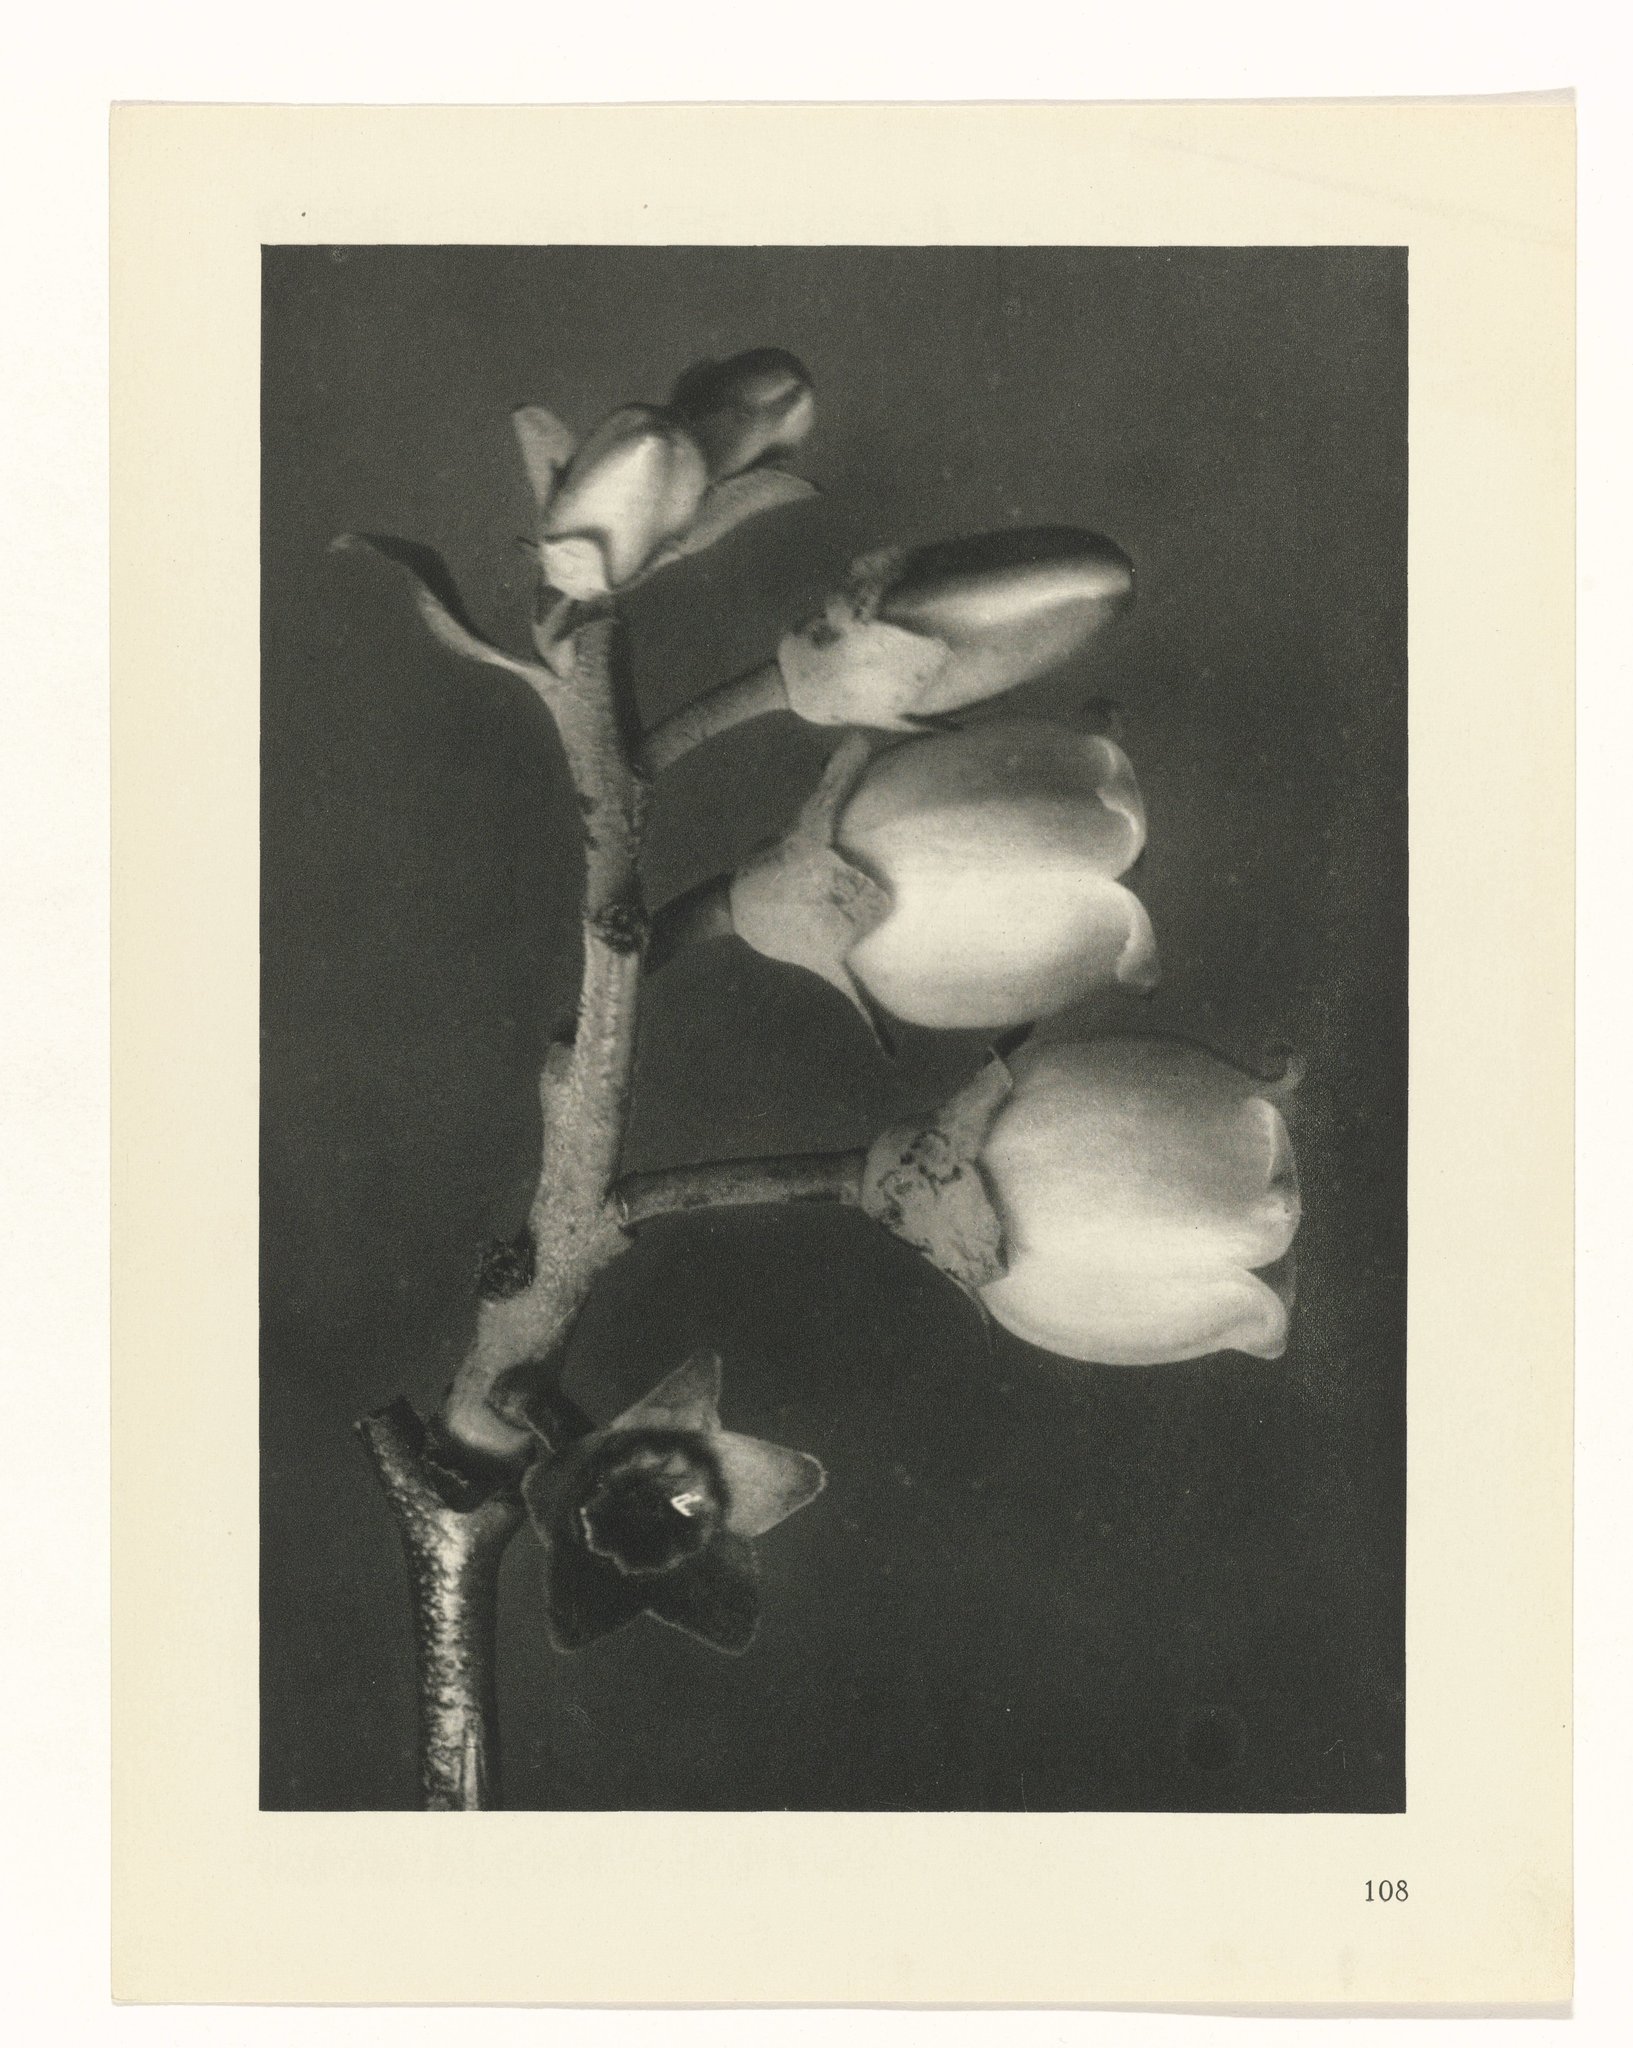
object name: photograph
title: Urformen der Kunst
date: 1928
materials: ink, paper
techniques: rotogravure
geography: berlin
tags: plants (in general)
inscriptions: number: ‘108’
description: facher Vergrößerung. Afkomstig uit losbladige uitgave.